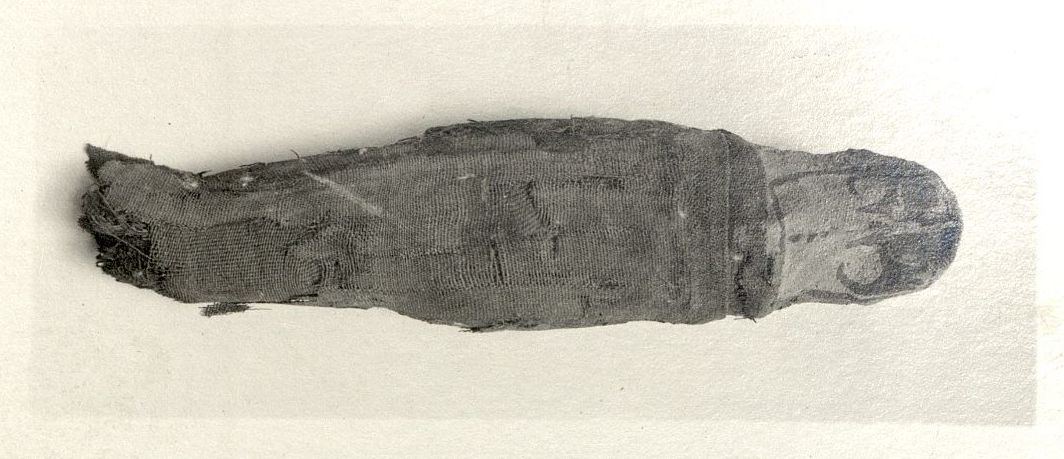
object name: mummy, falcon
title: Sacred animal mummy of falcon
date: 664-630 BCE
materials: linen, paint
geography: egypt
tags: falcons,mummies